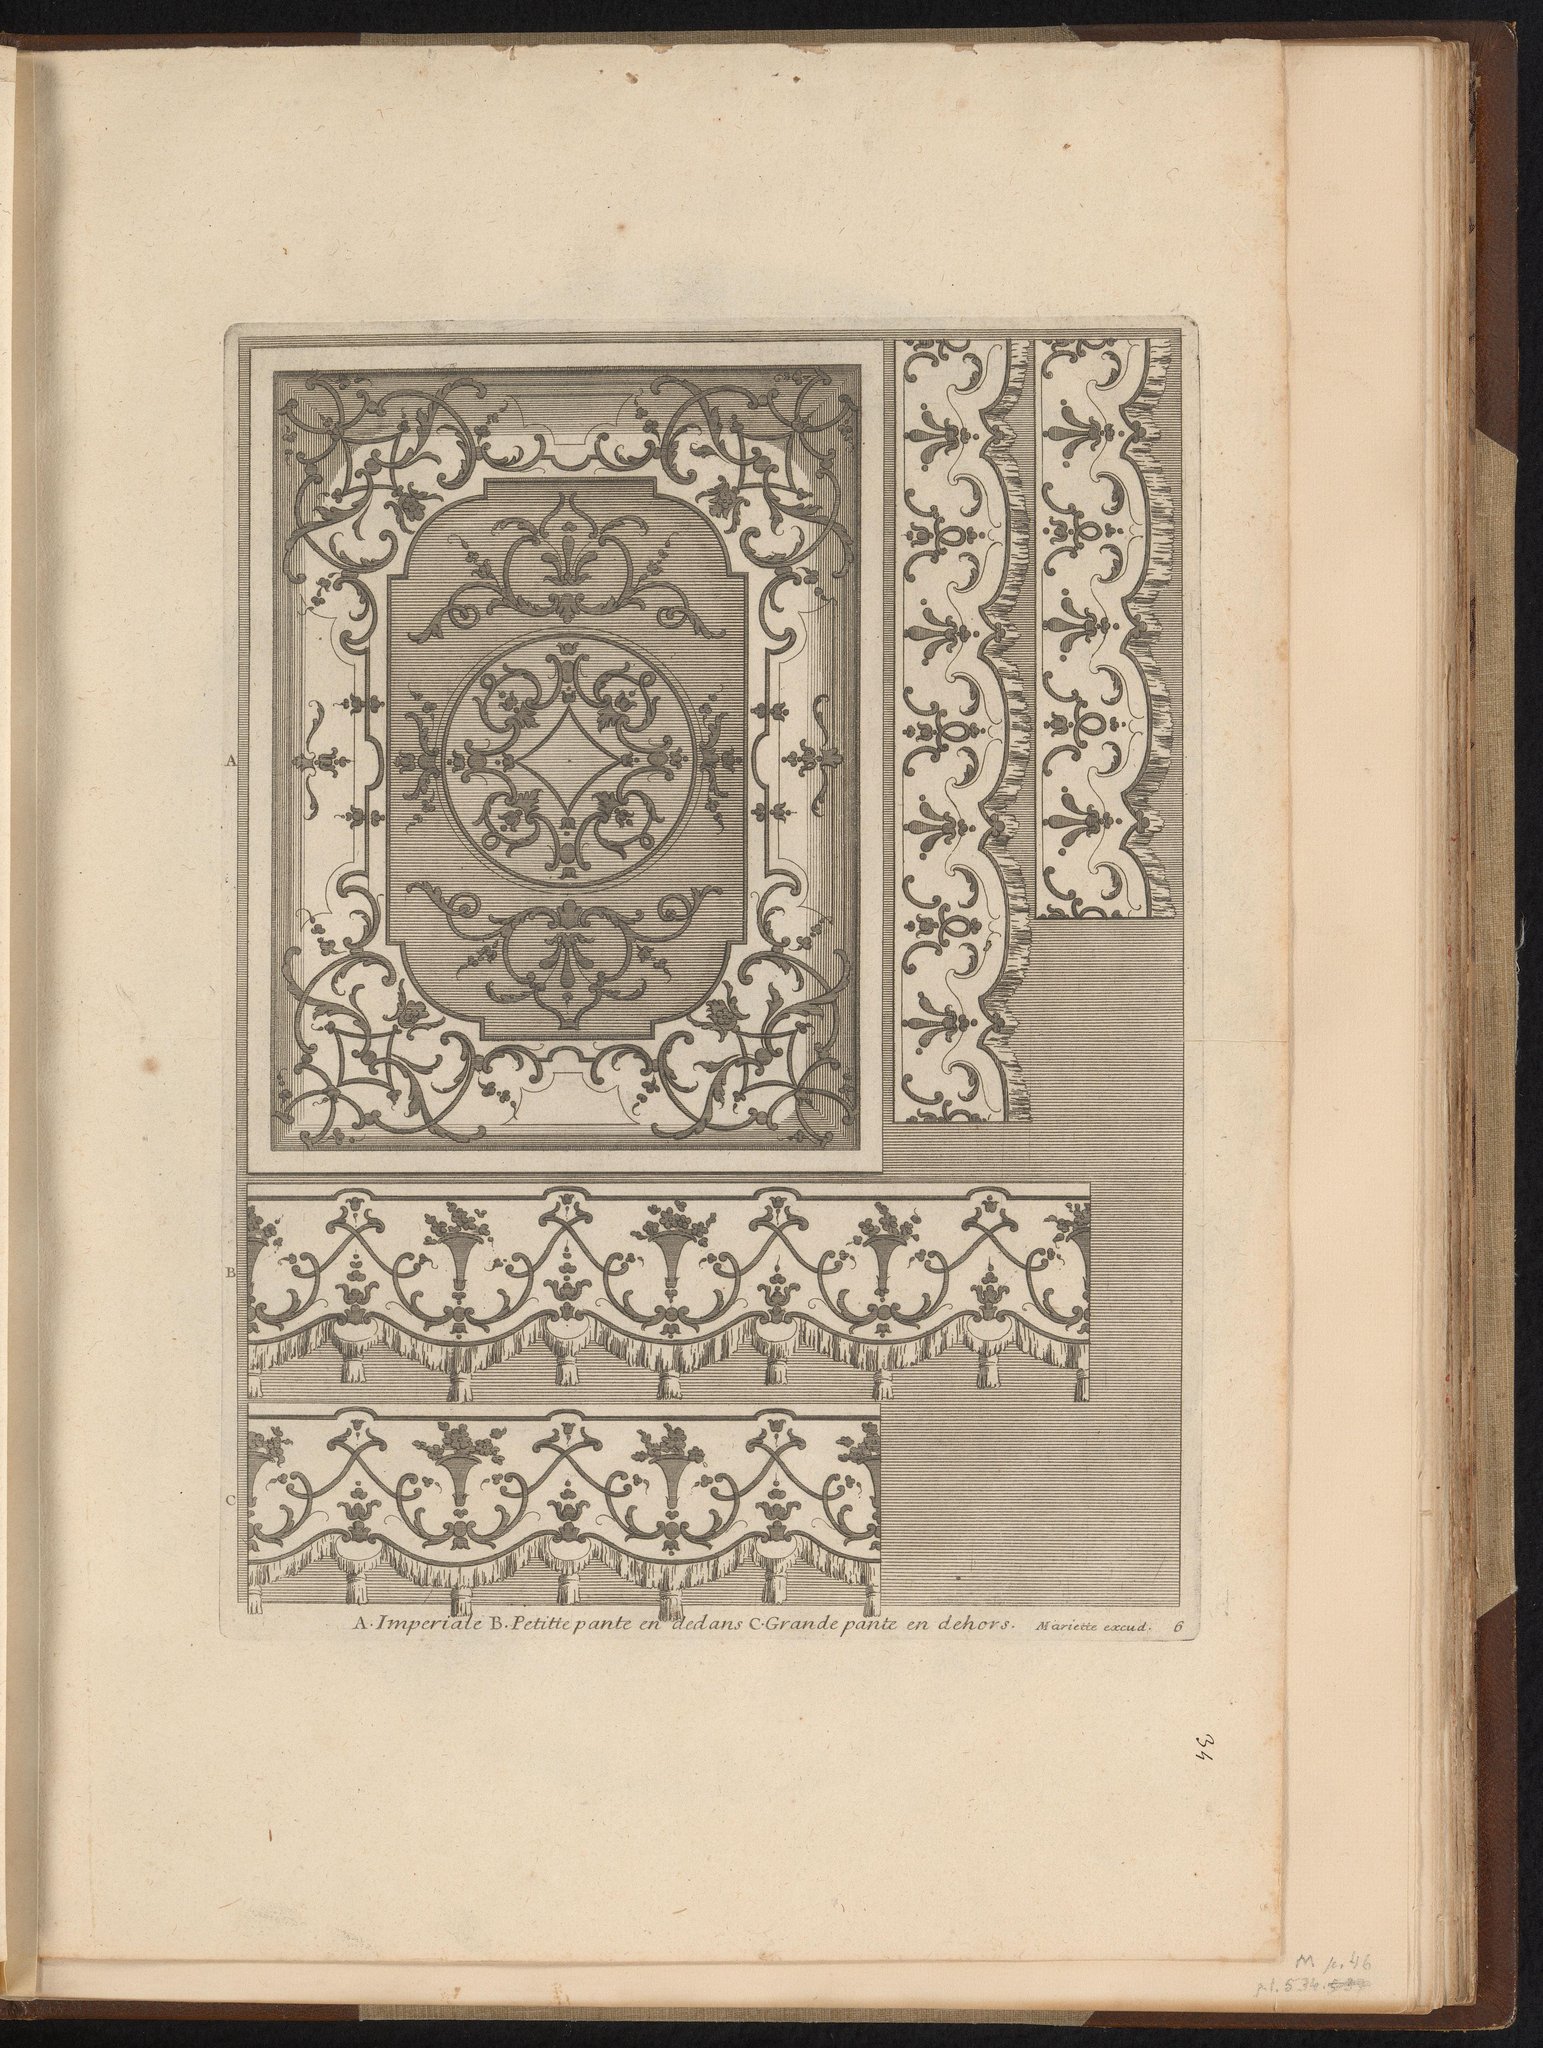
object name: print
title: Ontwerp voor panelen van een bed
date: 1725-1750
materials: paper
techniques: etching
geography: paris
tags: ornaments ~ art, bed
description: Deze prent maakt deel uit van een album.